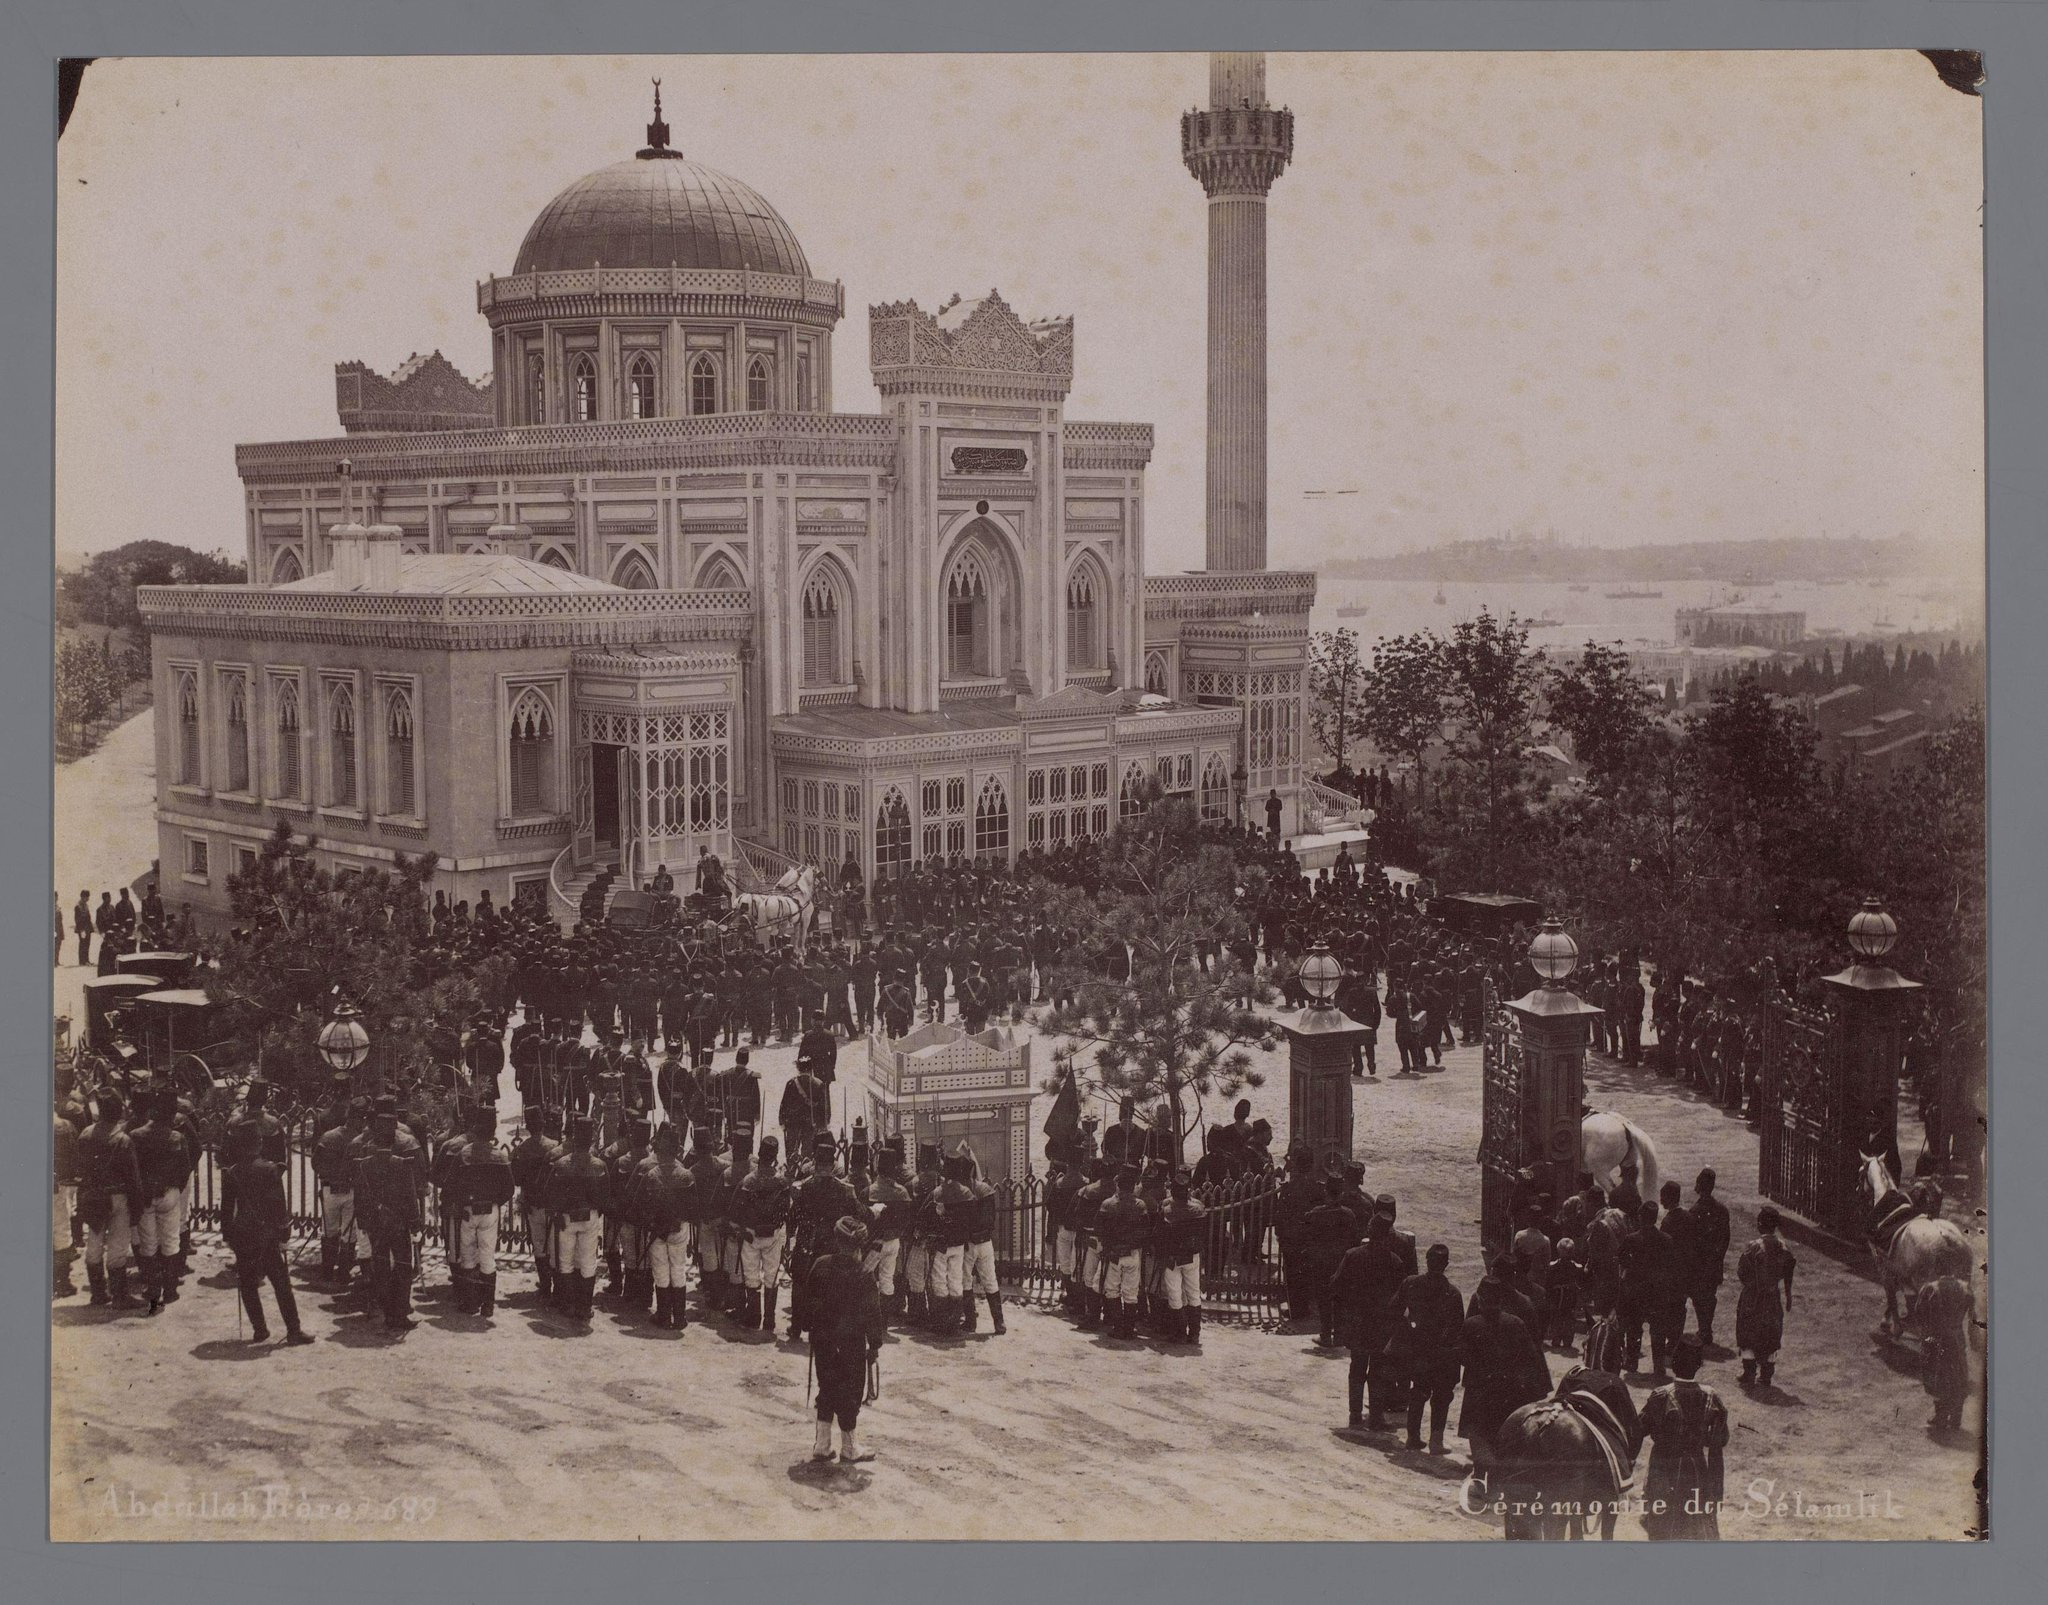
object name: photograph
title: Menigte tijdens de ontvangst van sultan Abdülhamit II voor het Salat al-djuma (vrijdagmiddaggebed) bij de Yildiz Hamidiye-moskee in Istanboel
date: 1876-1909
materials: paper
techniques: albumen print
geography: istanbul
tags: crowd, mob, temple, shrine ~ islam, mohammedanism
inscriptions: number: ‘689’